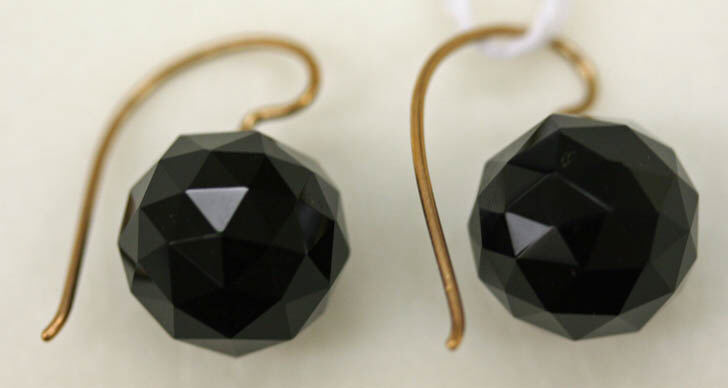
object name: earring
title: Earrings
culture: american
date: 1880-1889